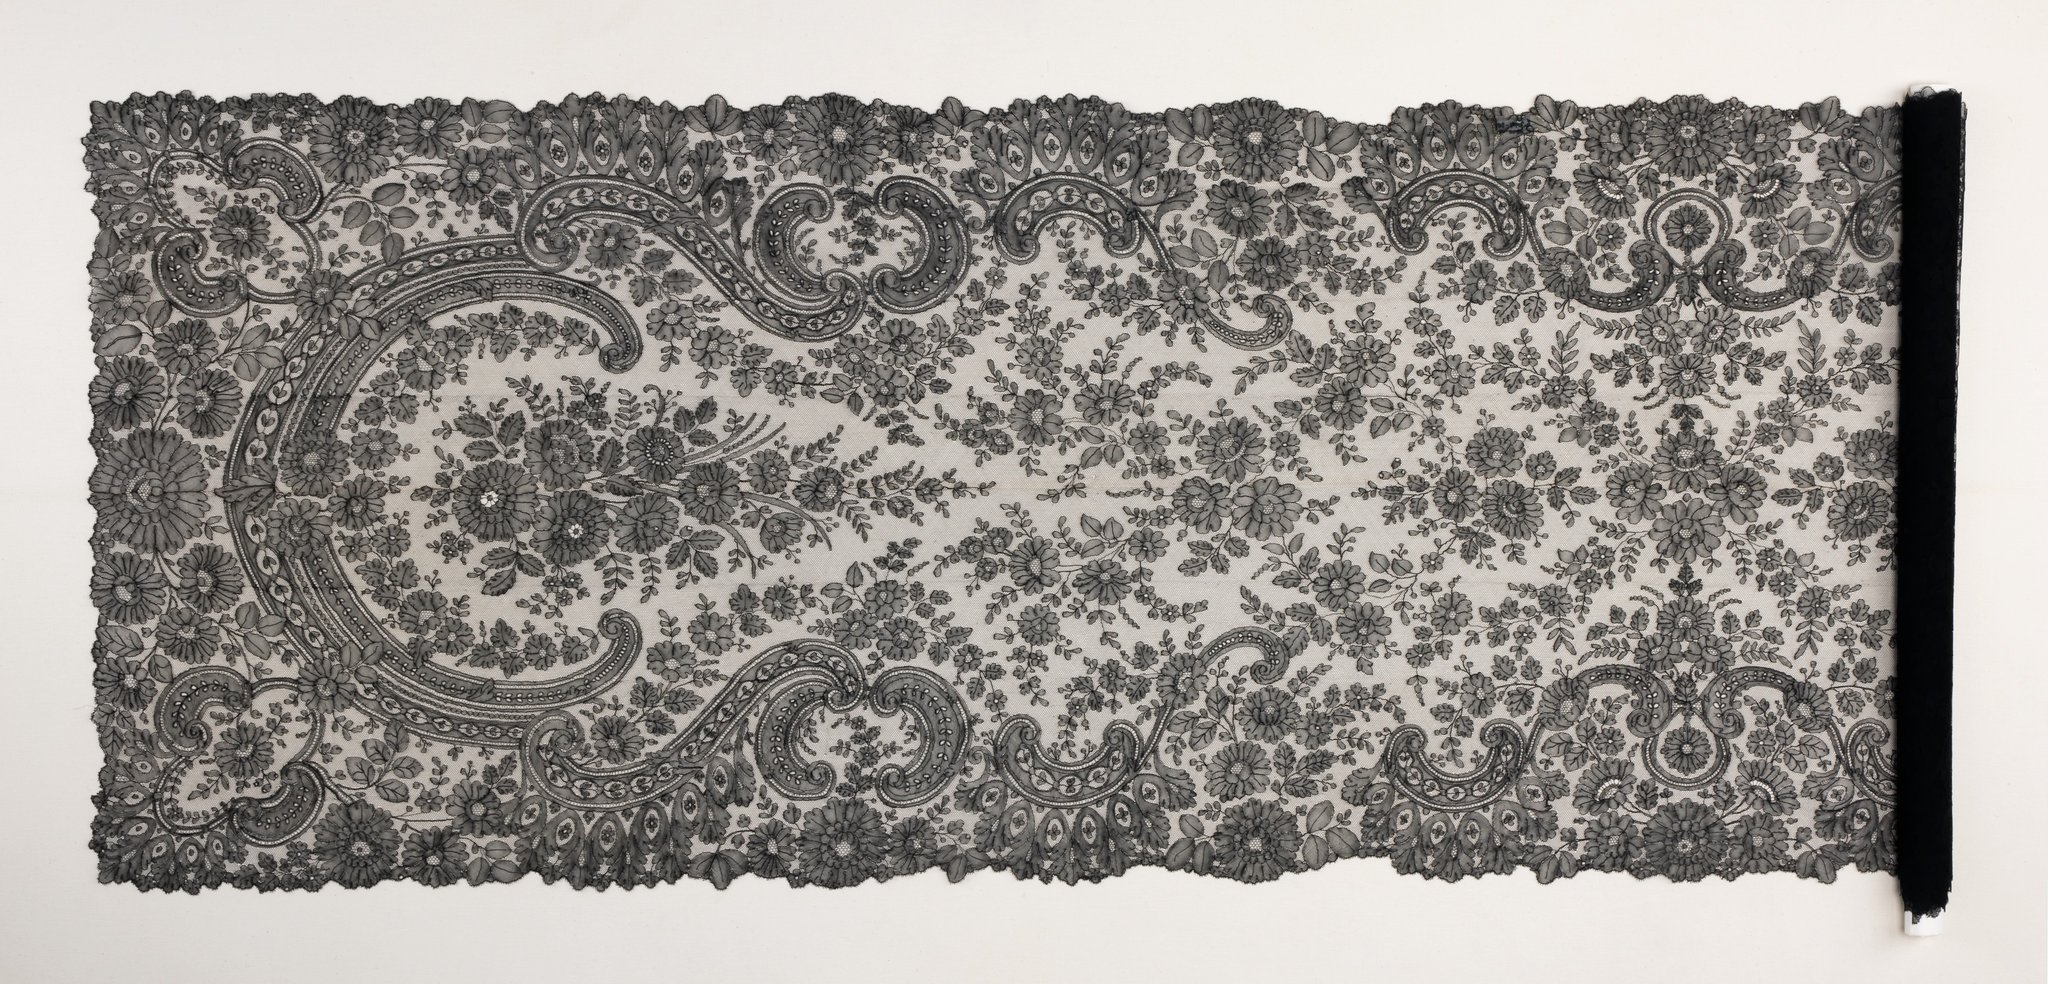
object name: shawl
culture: french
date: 1895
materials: silk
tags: flowers